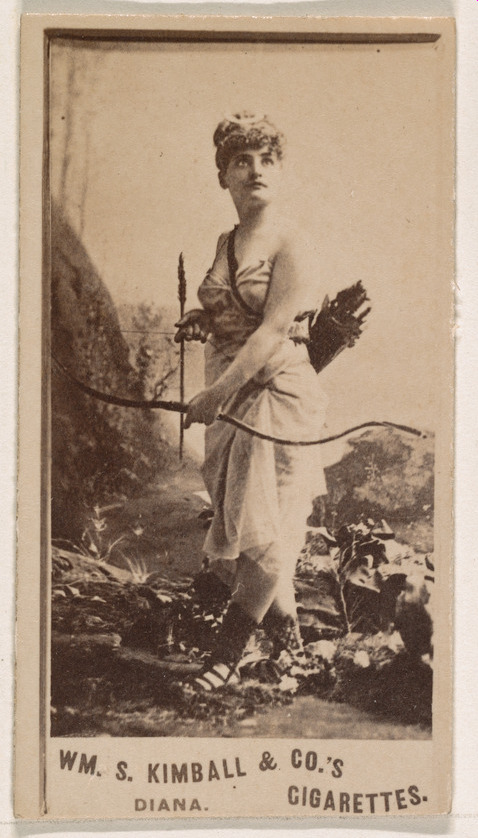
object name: photograph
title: Diana, from the Actresses series (N203) issued by Wm. S. Kimball & Co.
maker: william s. kimball & company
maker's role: publisher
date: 1889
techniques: color lithograph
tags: portraits,women,actresses